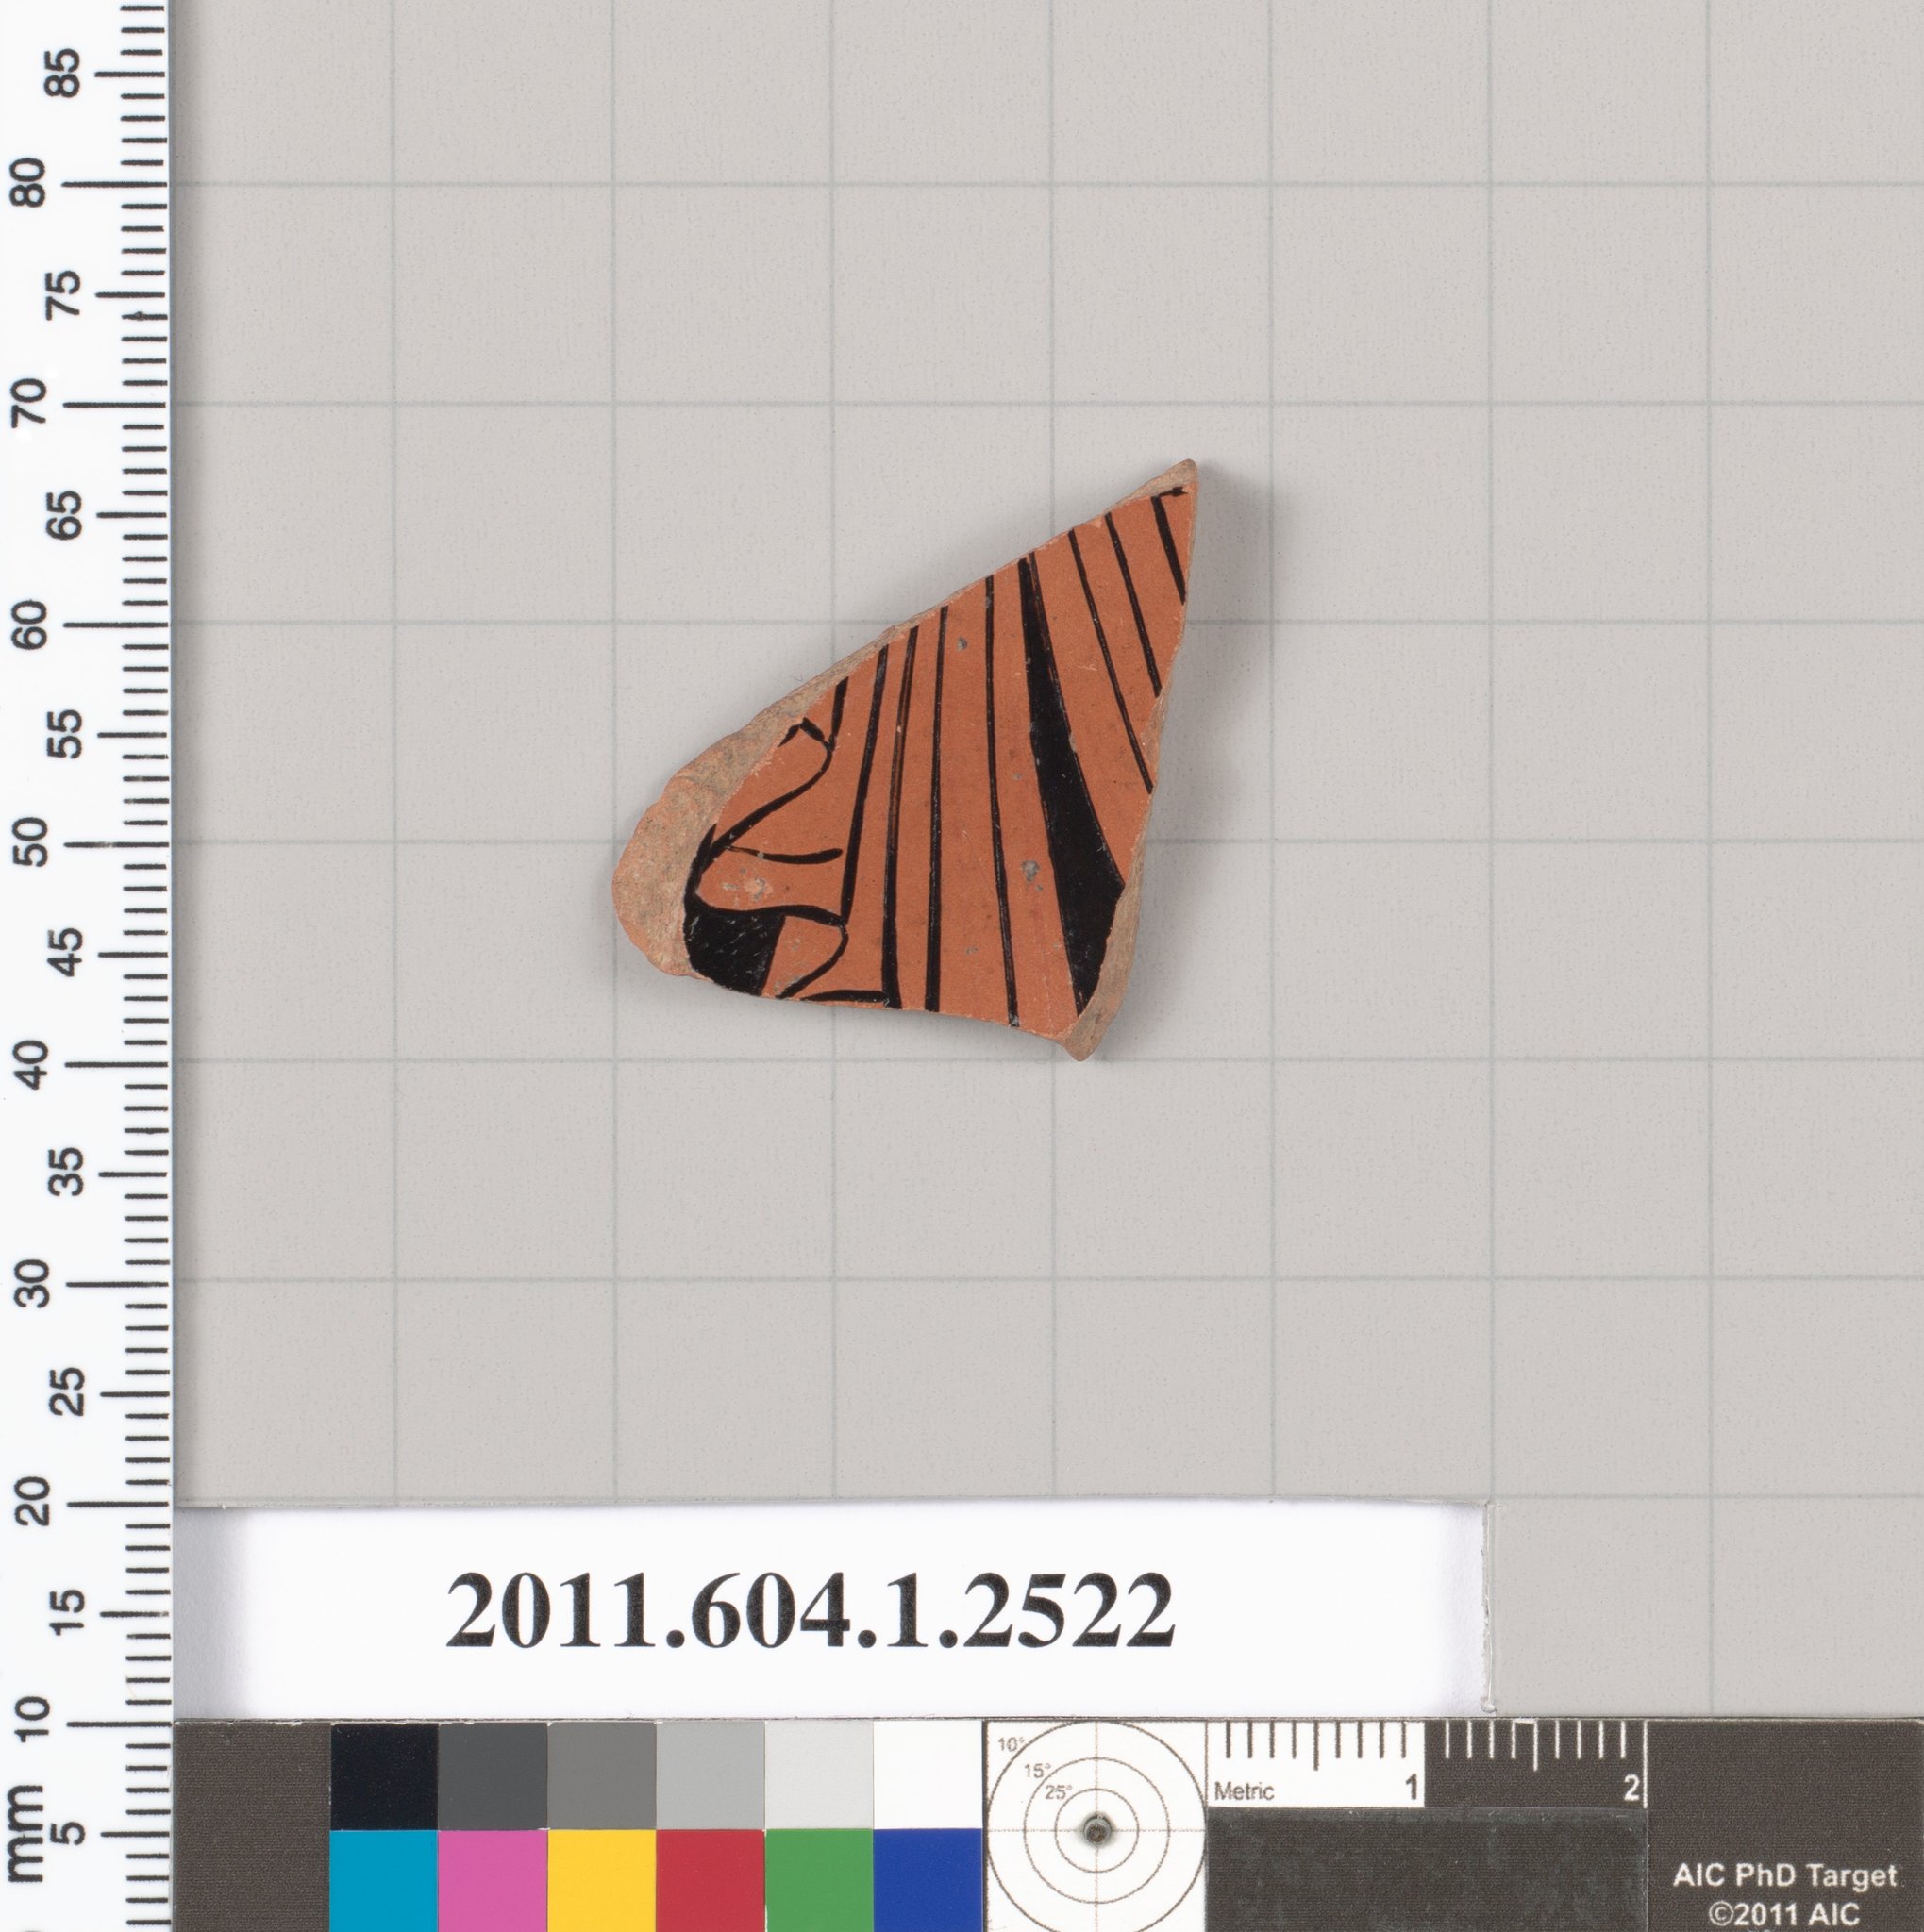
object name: kylix fragment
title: Terracotta fragment of a kylix (drinking cup)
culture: greek, attic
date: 490-480 BCE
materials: terracotta